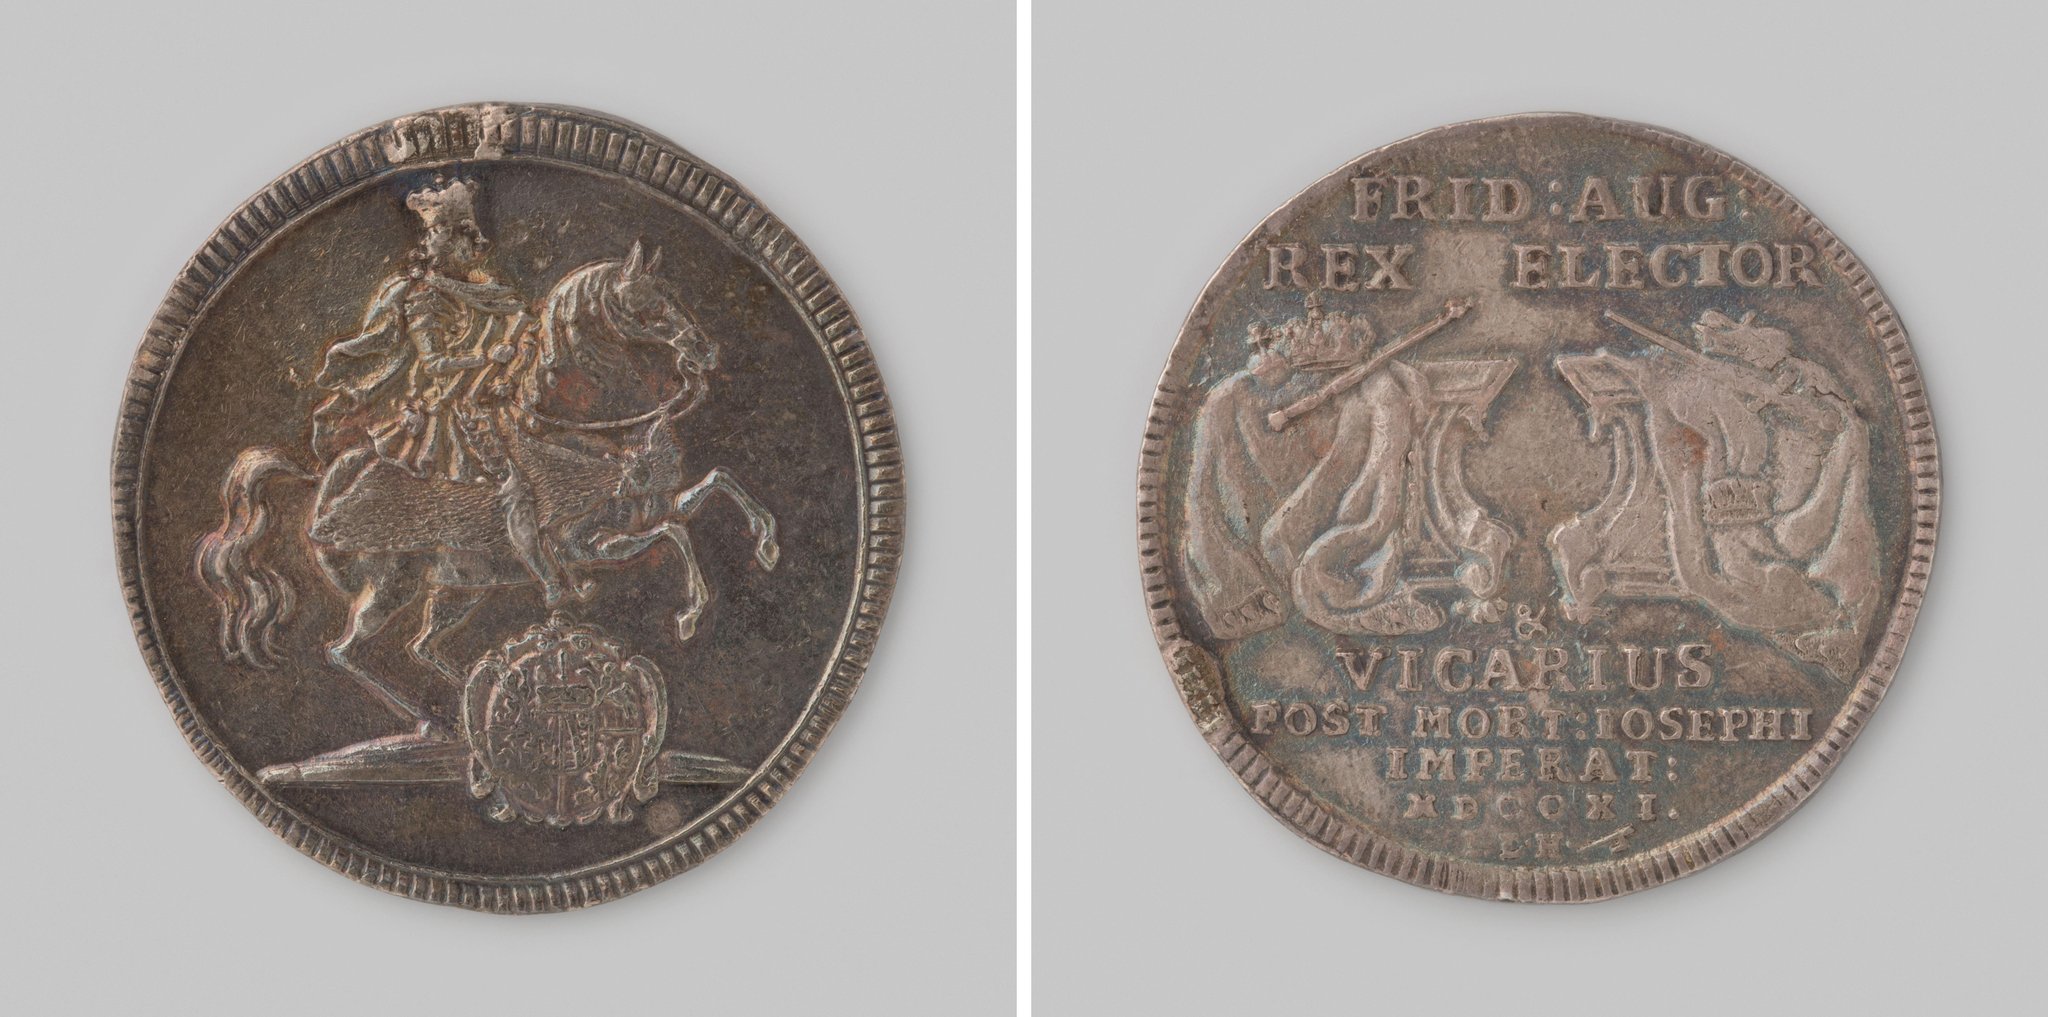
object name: history medal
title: Frederik August van Saksen Koning van Polen 1711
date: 1711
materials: silver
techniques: striking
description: Zilveren penning, op de voorzijde Frederik August te paard naar rechts, boven een versierd wapenschild, op de keerzijde twee tafels waarop de Saksische regalia te midden van zeven regels tekst.